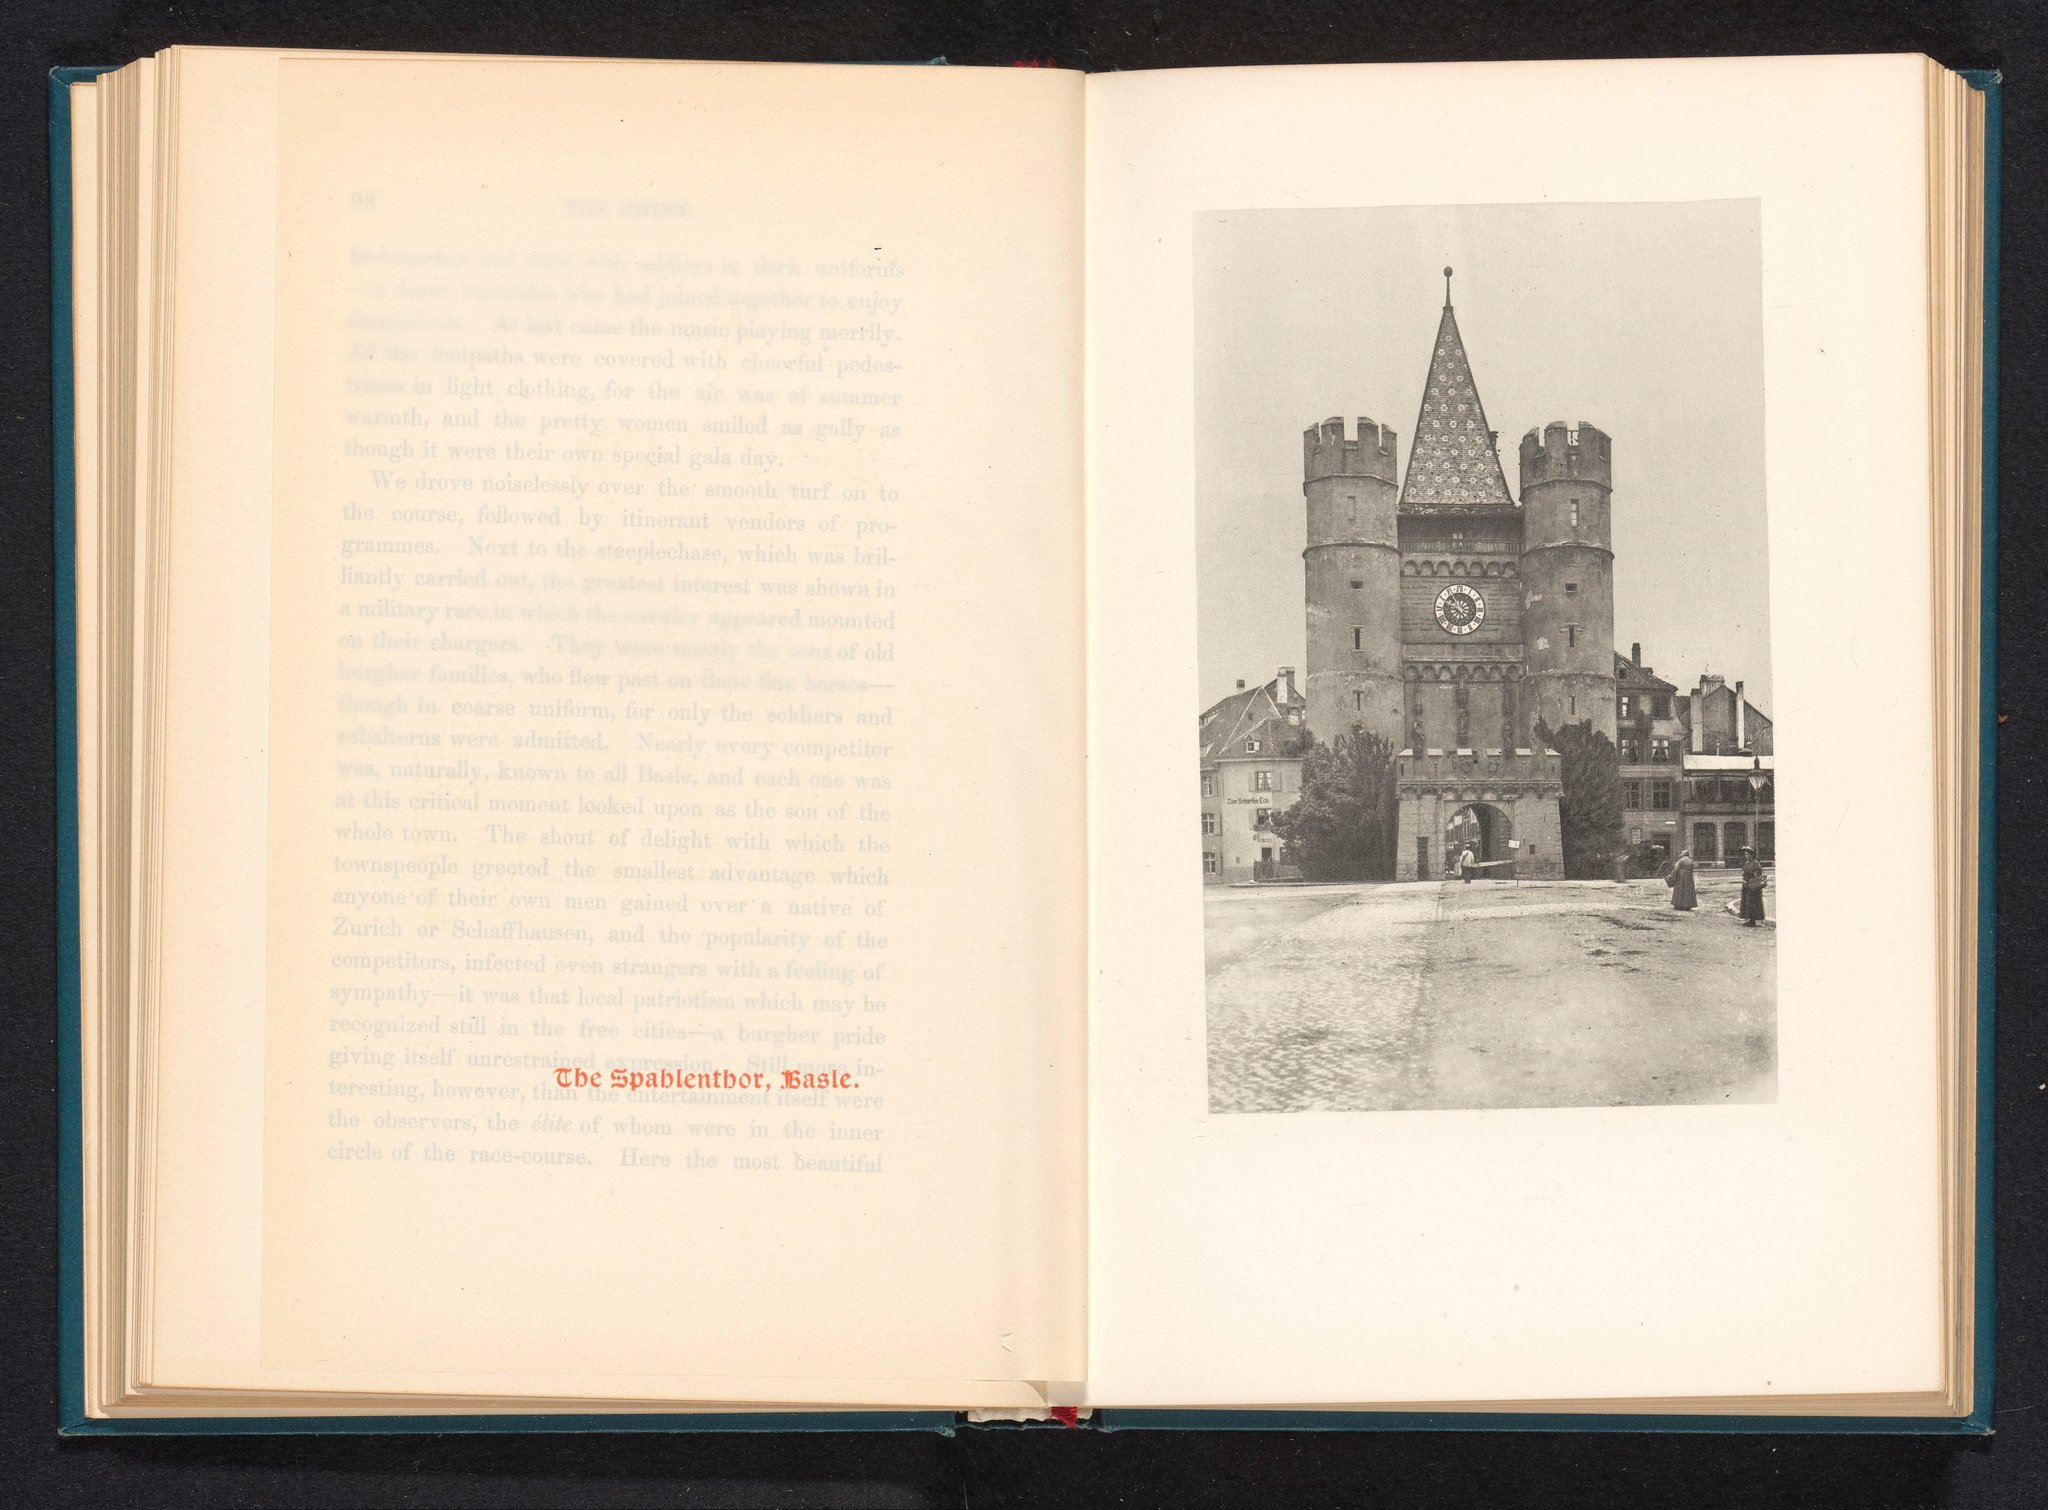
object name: photomechanical print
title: Gezicht op de Spalentor te Basel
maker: Anonymous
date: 1889-1899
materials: paper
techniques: photoaquatint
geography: basel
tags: city-gate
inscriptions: title: ‘The Spahlentor, Basle.’